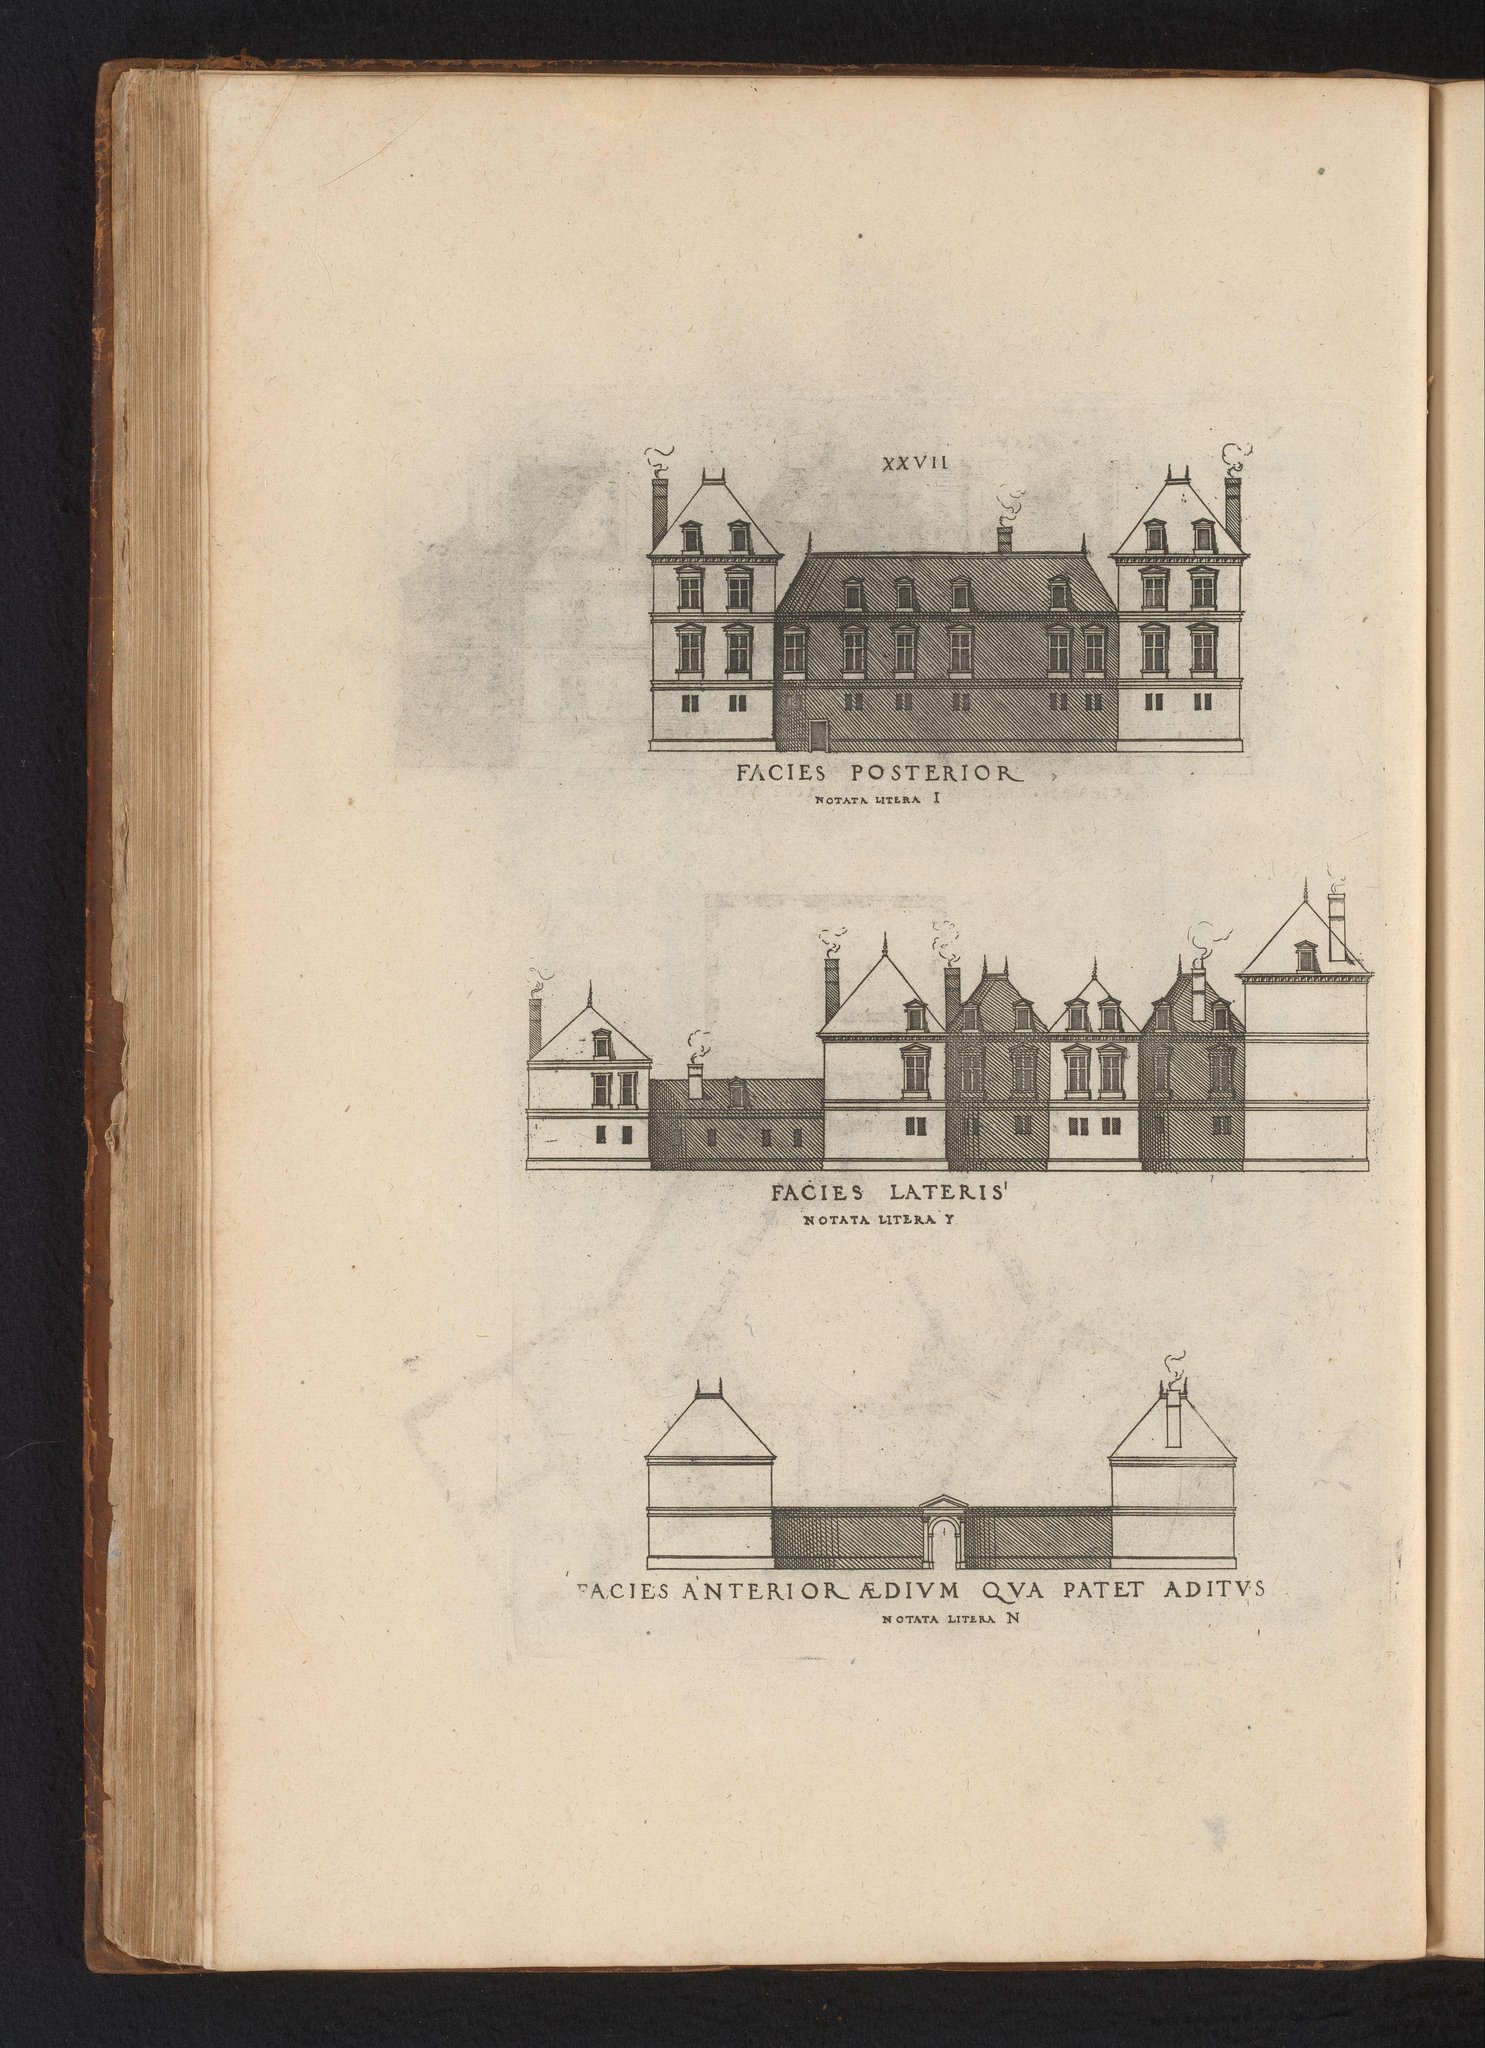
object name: ornament print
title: Achtergevels en zijgevel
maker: jacques androuet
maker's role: draughtsman, print maker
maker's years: 1515-1584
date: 1559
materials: paper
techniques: etching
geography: paris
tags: architectural design or model, façade (of house or building)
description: Twee achtergevels en zijgevel. Aanzicht van architectuur. Genummerd: XXVII. Onderdeel van 'De architectura Iacobi Androuetii du Cerceau' (1559): 69 etsen met 171 voorstellingen van architectuur en ornamentiek.